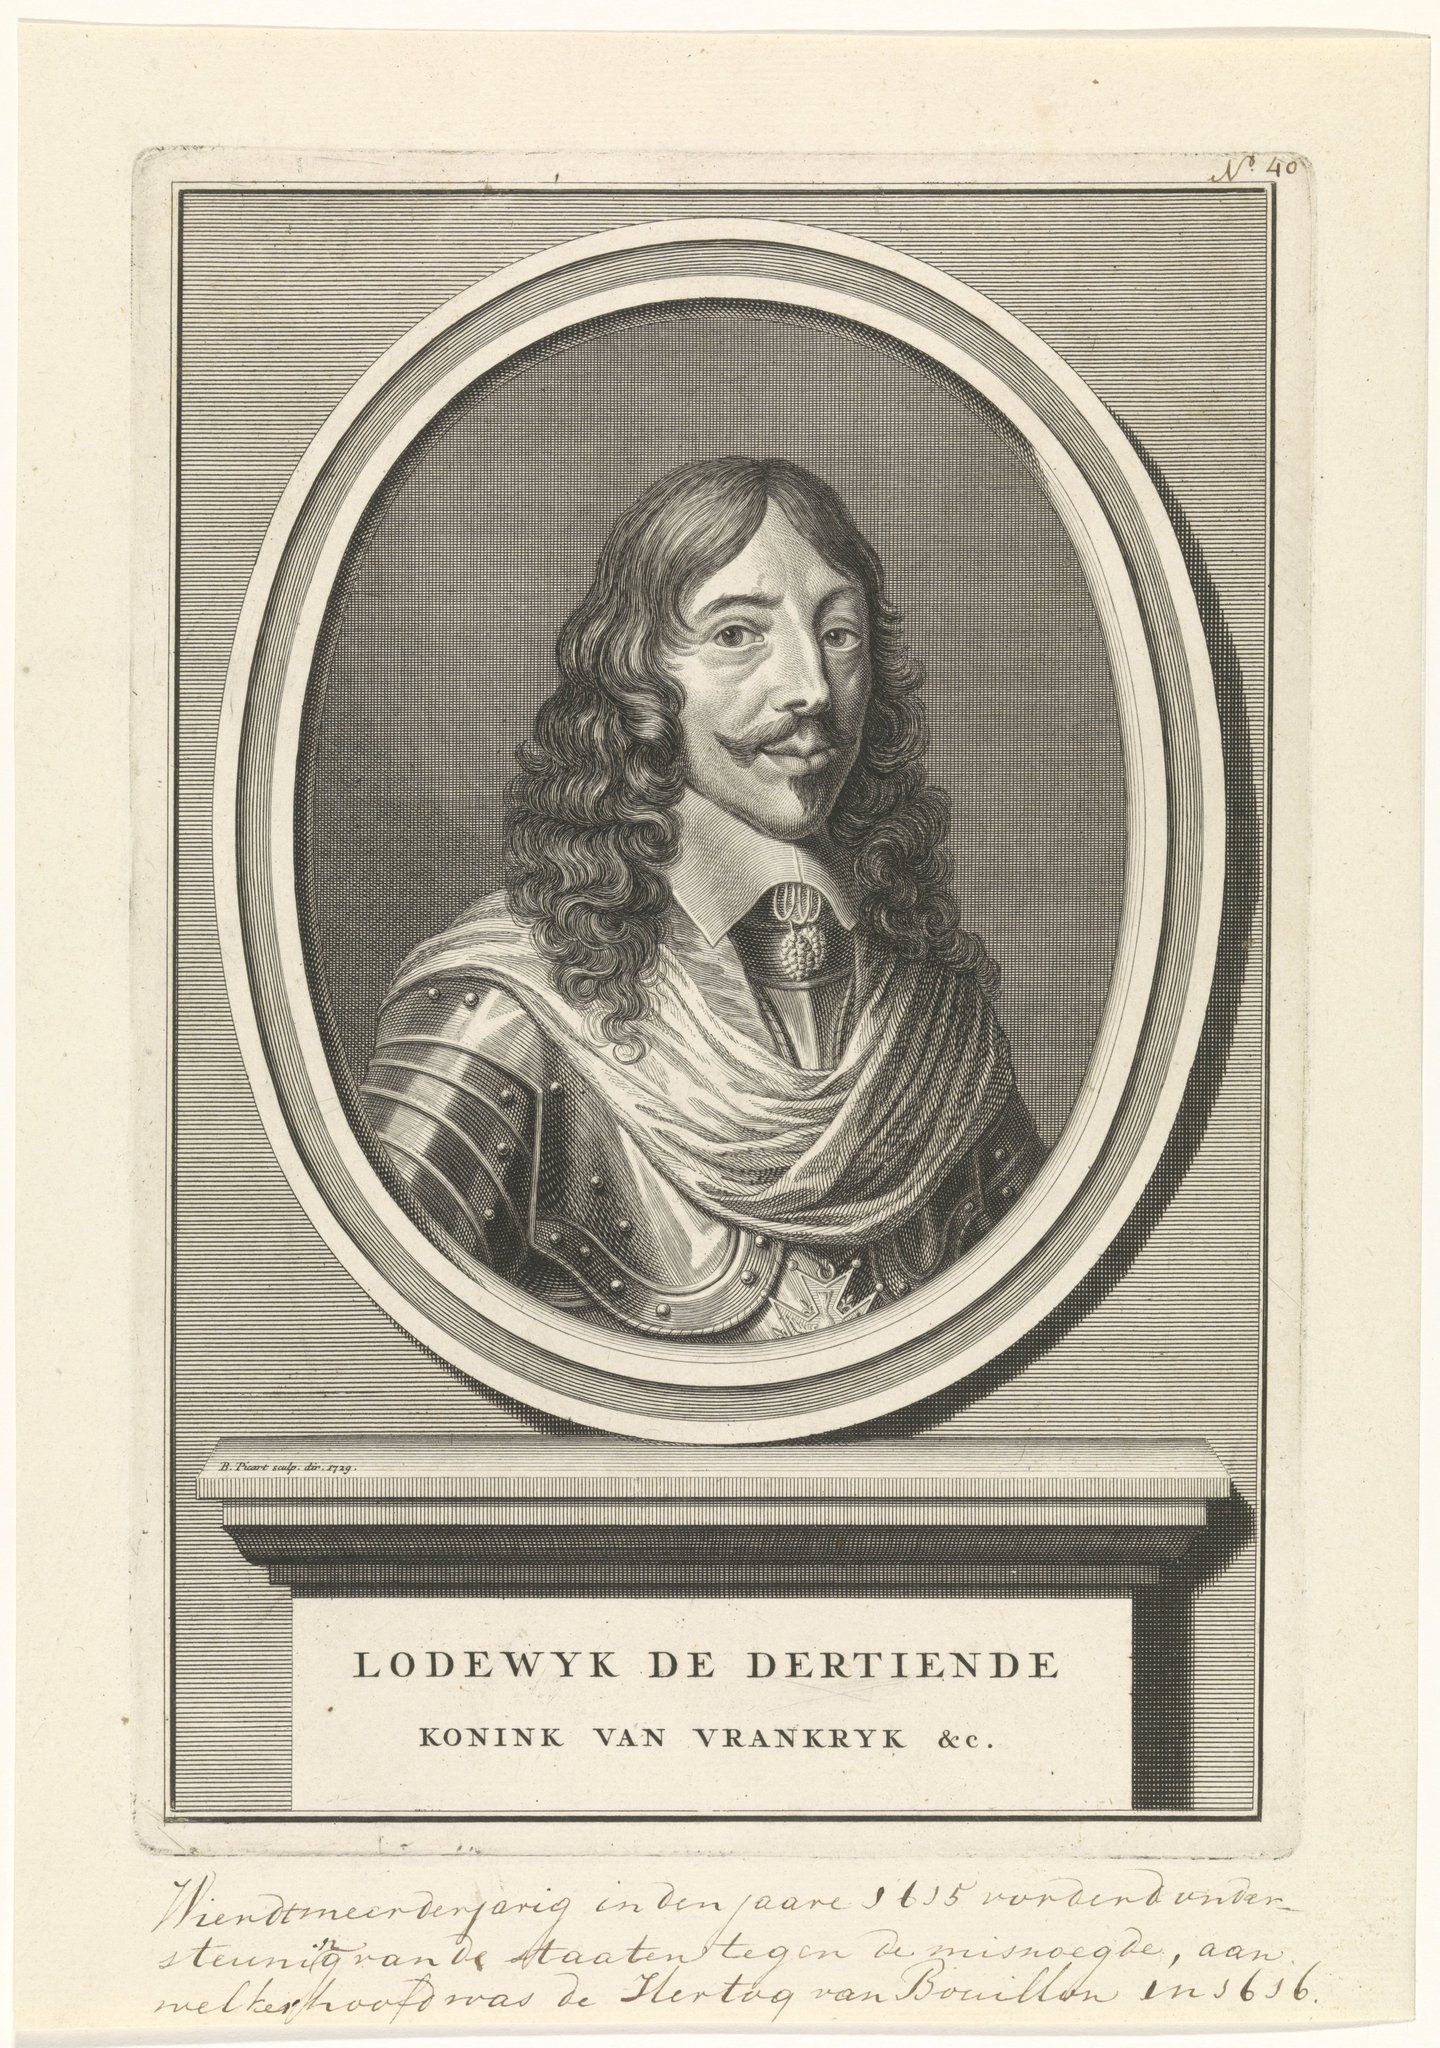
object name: print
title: Portret van Lodewijk XIII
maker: bernard picart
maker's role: draughtsman, print maker, publisher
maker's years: 1673-1733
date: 1729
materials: paper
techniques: engraving, etching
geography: amsterdam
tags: lodewijk xiii (koning van frankrijk), armour, knighthood order of the holy spirit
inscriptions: inscription: ‘Wiendtmeerderjarig [...] in 1616.’, number: ‘N. 40’, collector's mark: Lugt 2228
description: Portret van Lodewijk XIII, koning van Frankrijk. Hij draagt een lint met de Orde van de Heilige Geest.